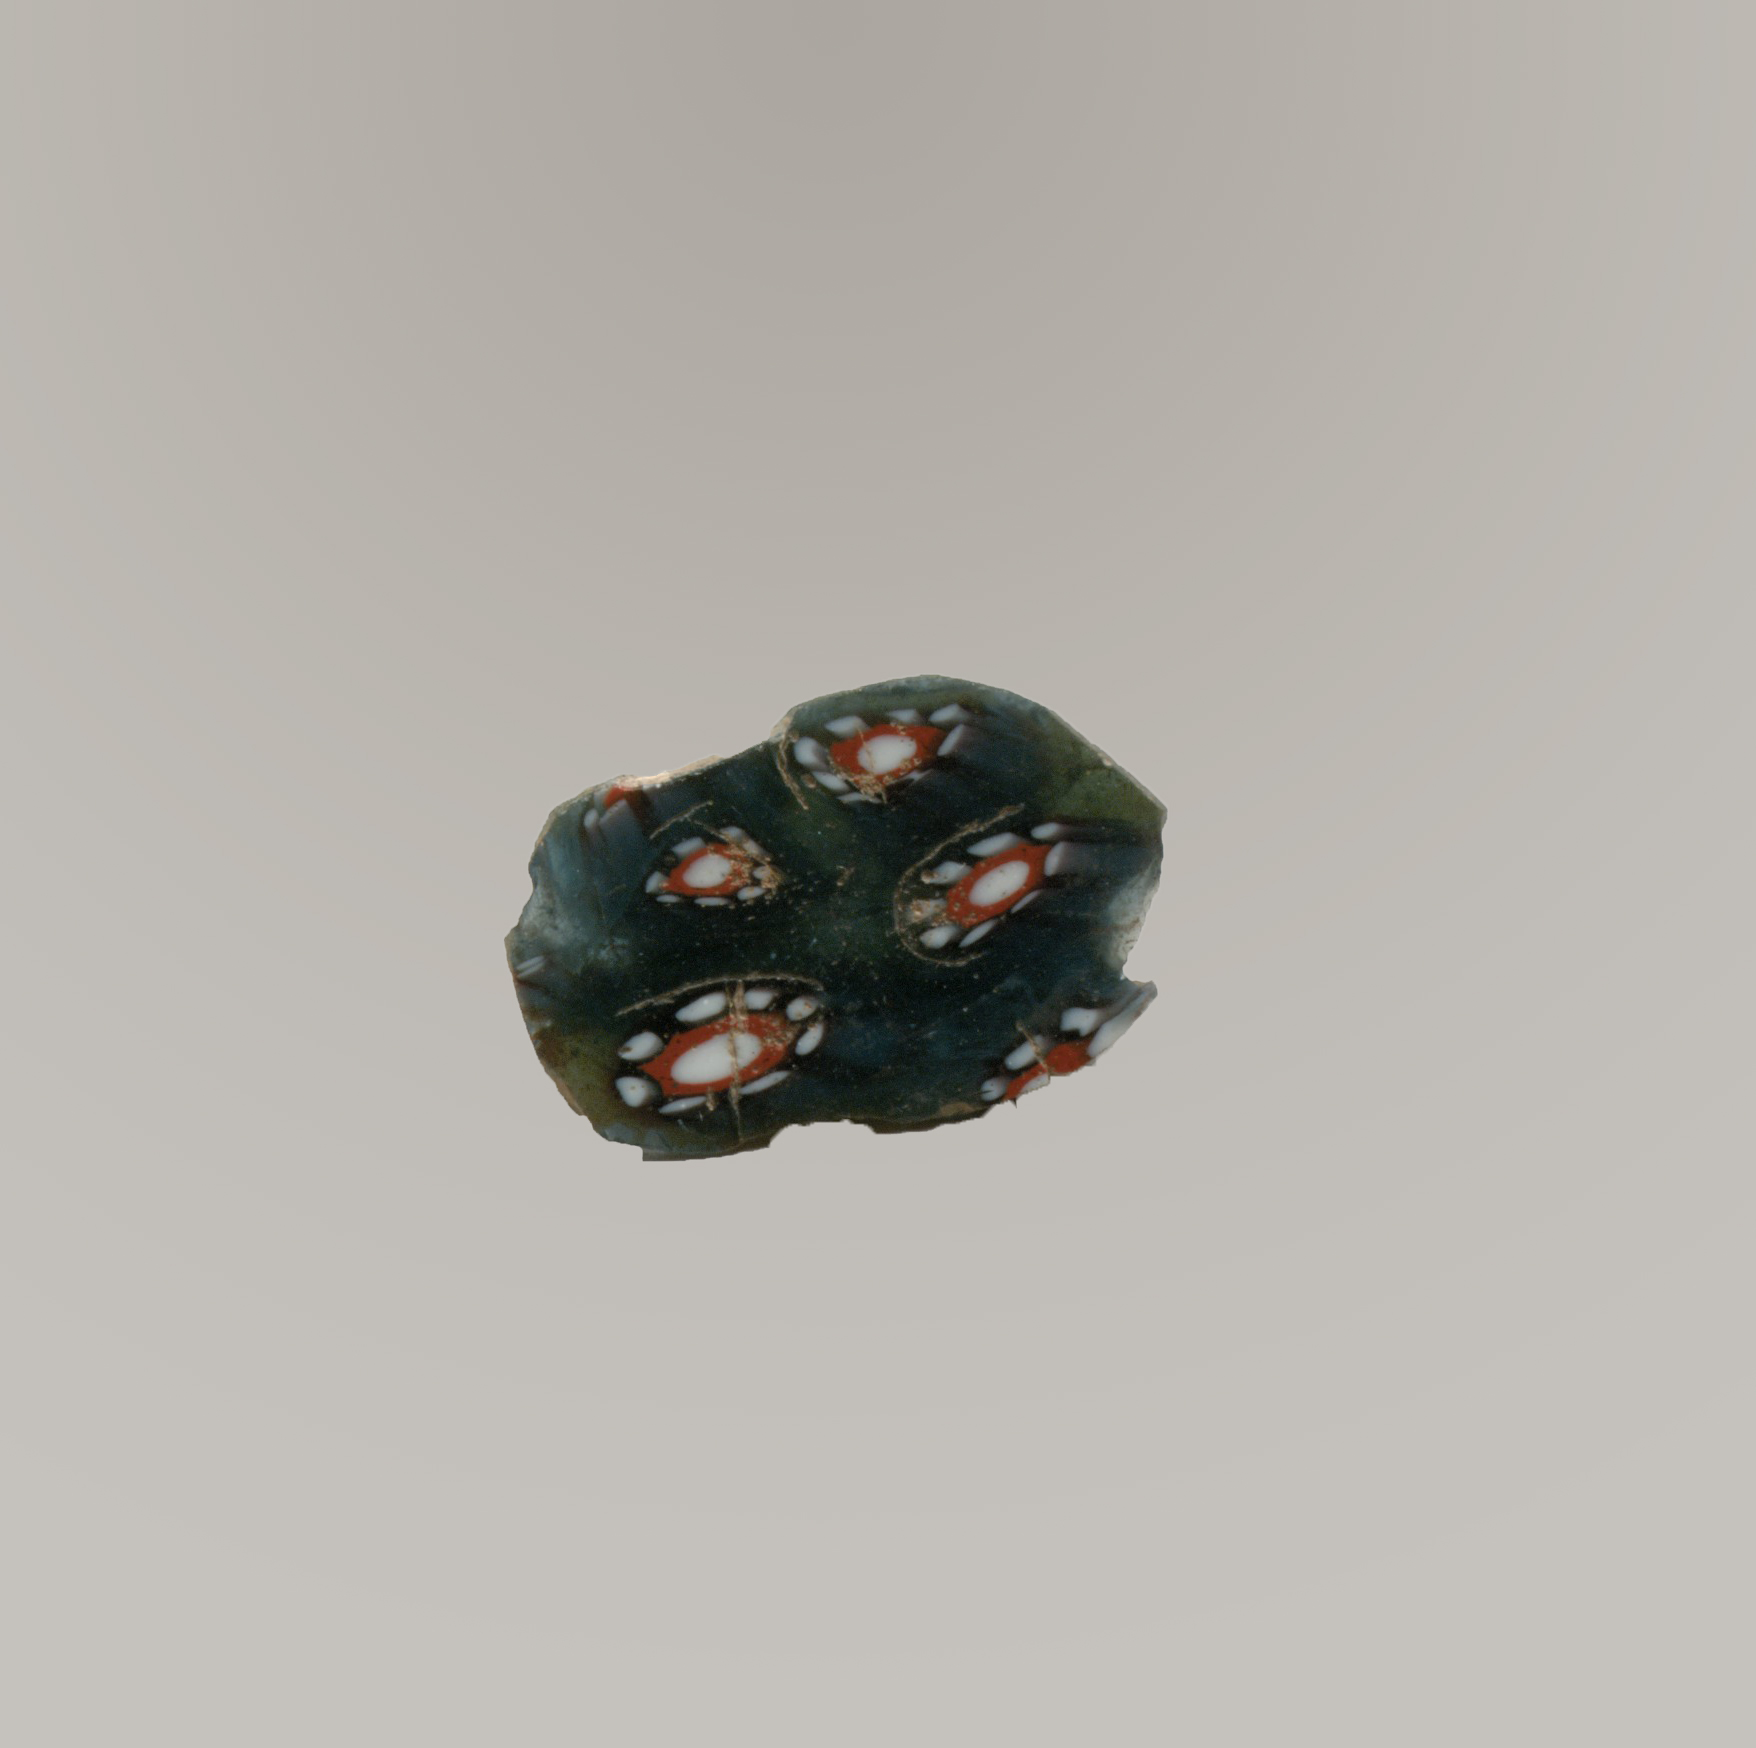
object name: fragment, mosaic bowl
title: Glass mosaic bowl fragment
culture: roman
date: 34 BCE-33 CE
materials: glass